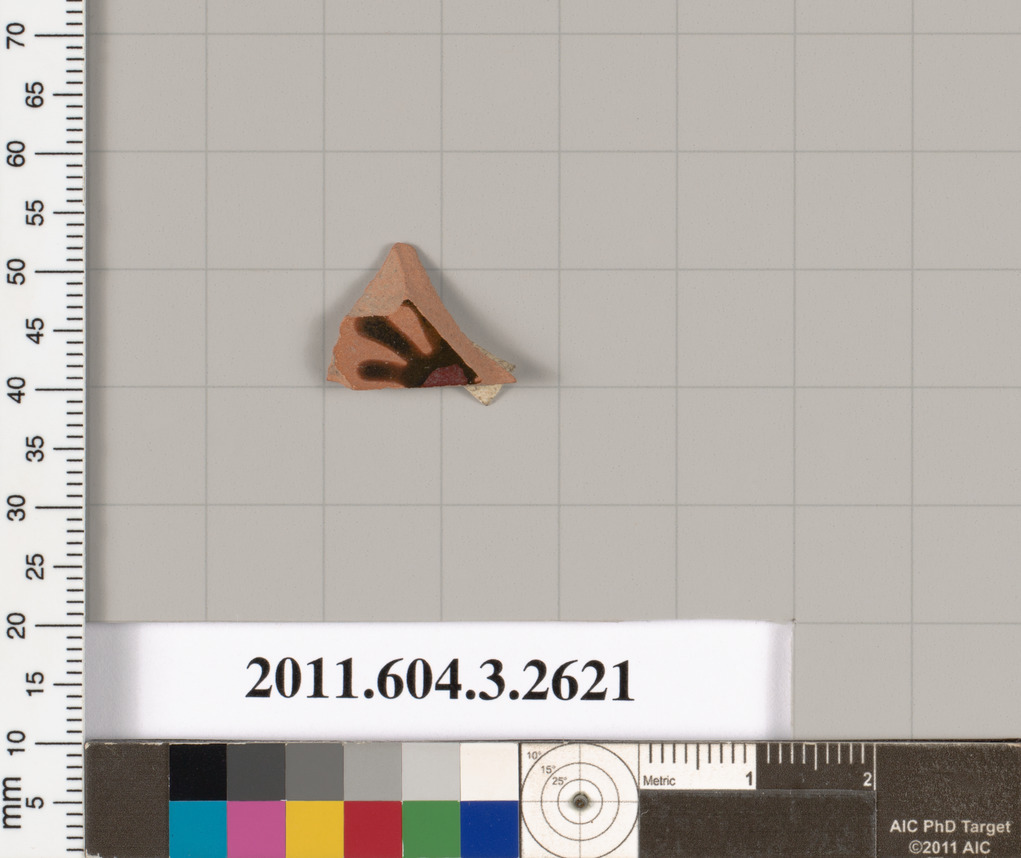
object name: kylix fragment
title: Terracotta fragment of a kylix (drinking cup)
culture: greek, attic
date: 525-501 BCE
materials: terracotta